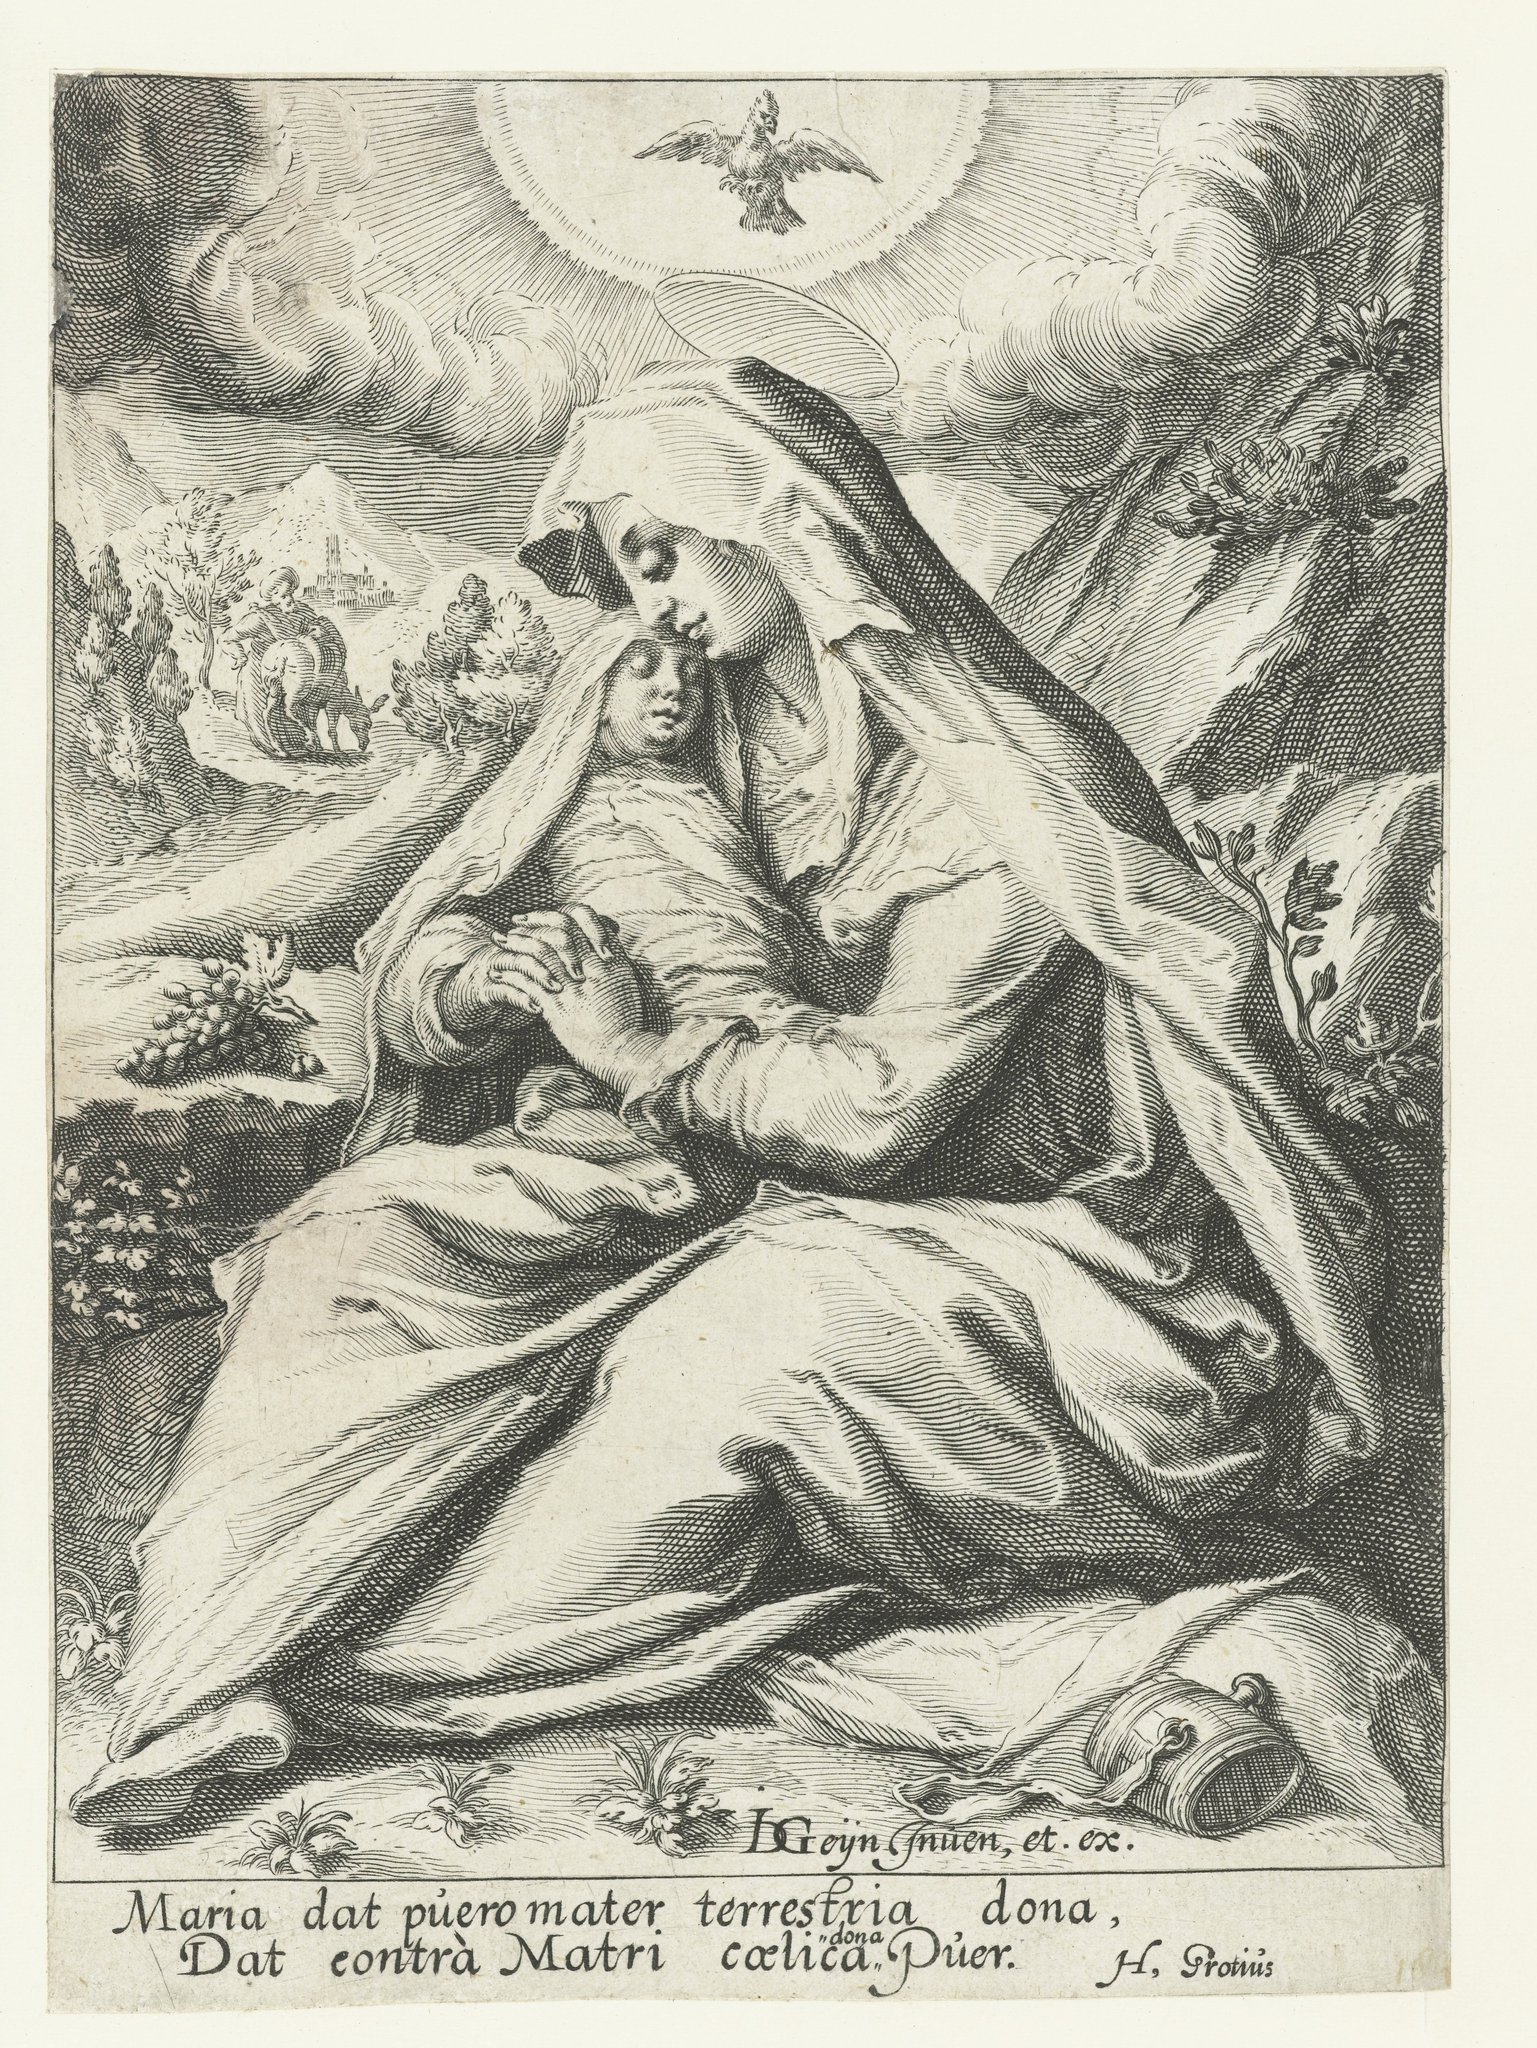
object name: print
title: Rest on the Flight into Egypt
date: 1593-1597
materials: paper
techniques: engraving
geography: netherlands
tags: rest on the flight into egypt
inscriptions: collector's mark: Lugt 240, collector's mark: Lugt 2228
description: Maria zit met het Christuskind op schoot in een bergachtige omgeving. Een duif prijkt in stralenkrans boven haar hoofd. Op de achtergrond staat Jozef bij een ezel. Onder de voorstelling een tweeregelige Latijnse tekst.